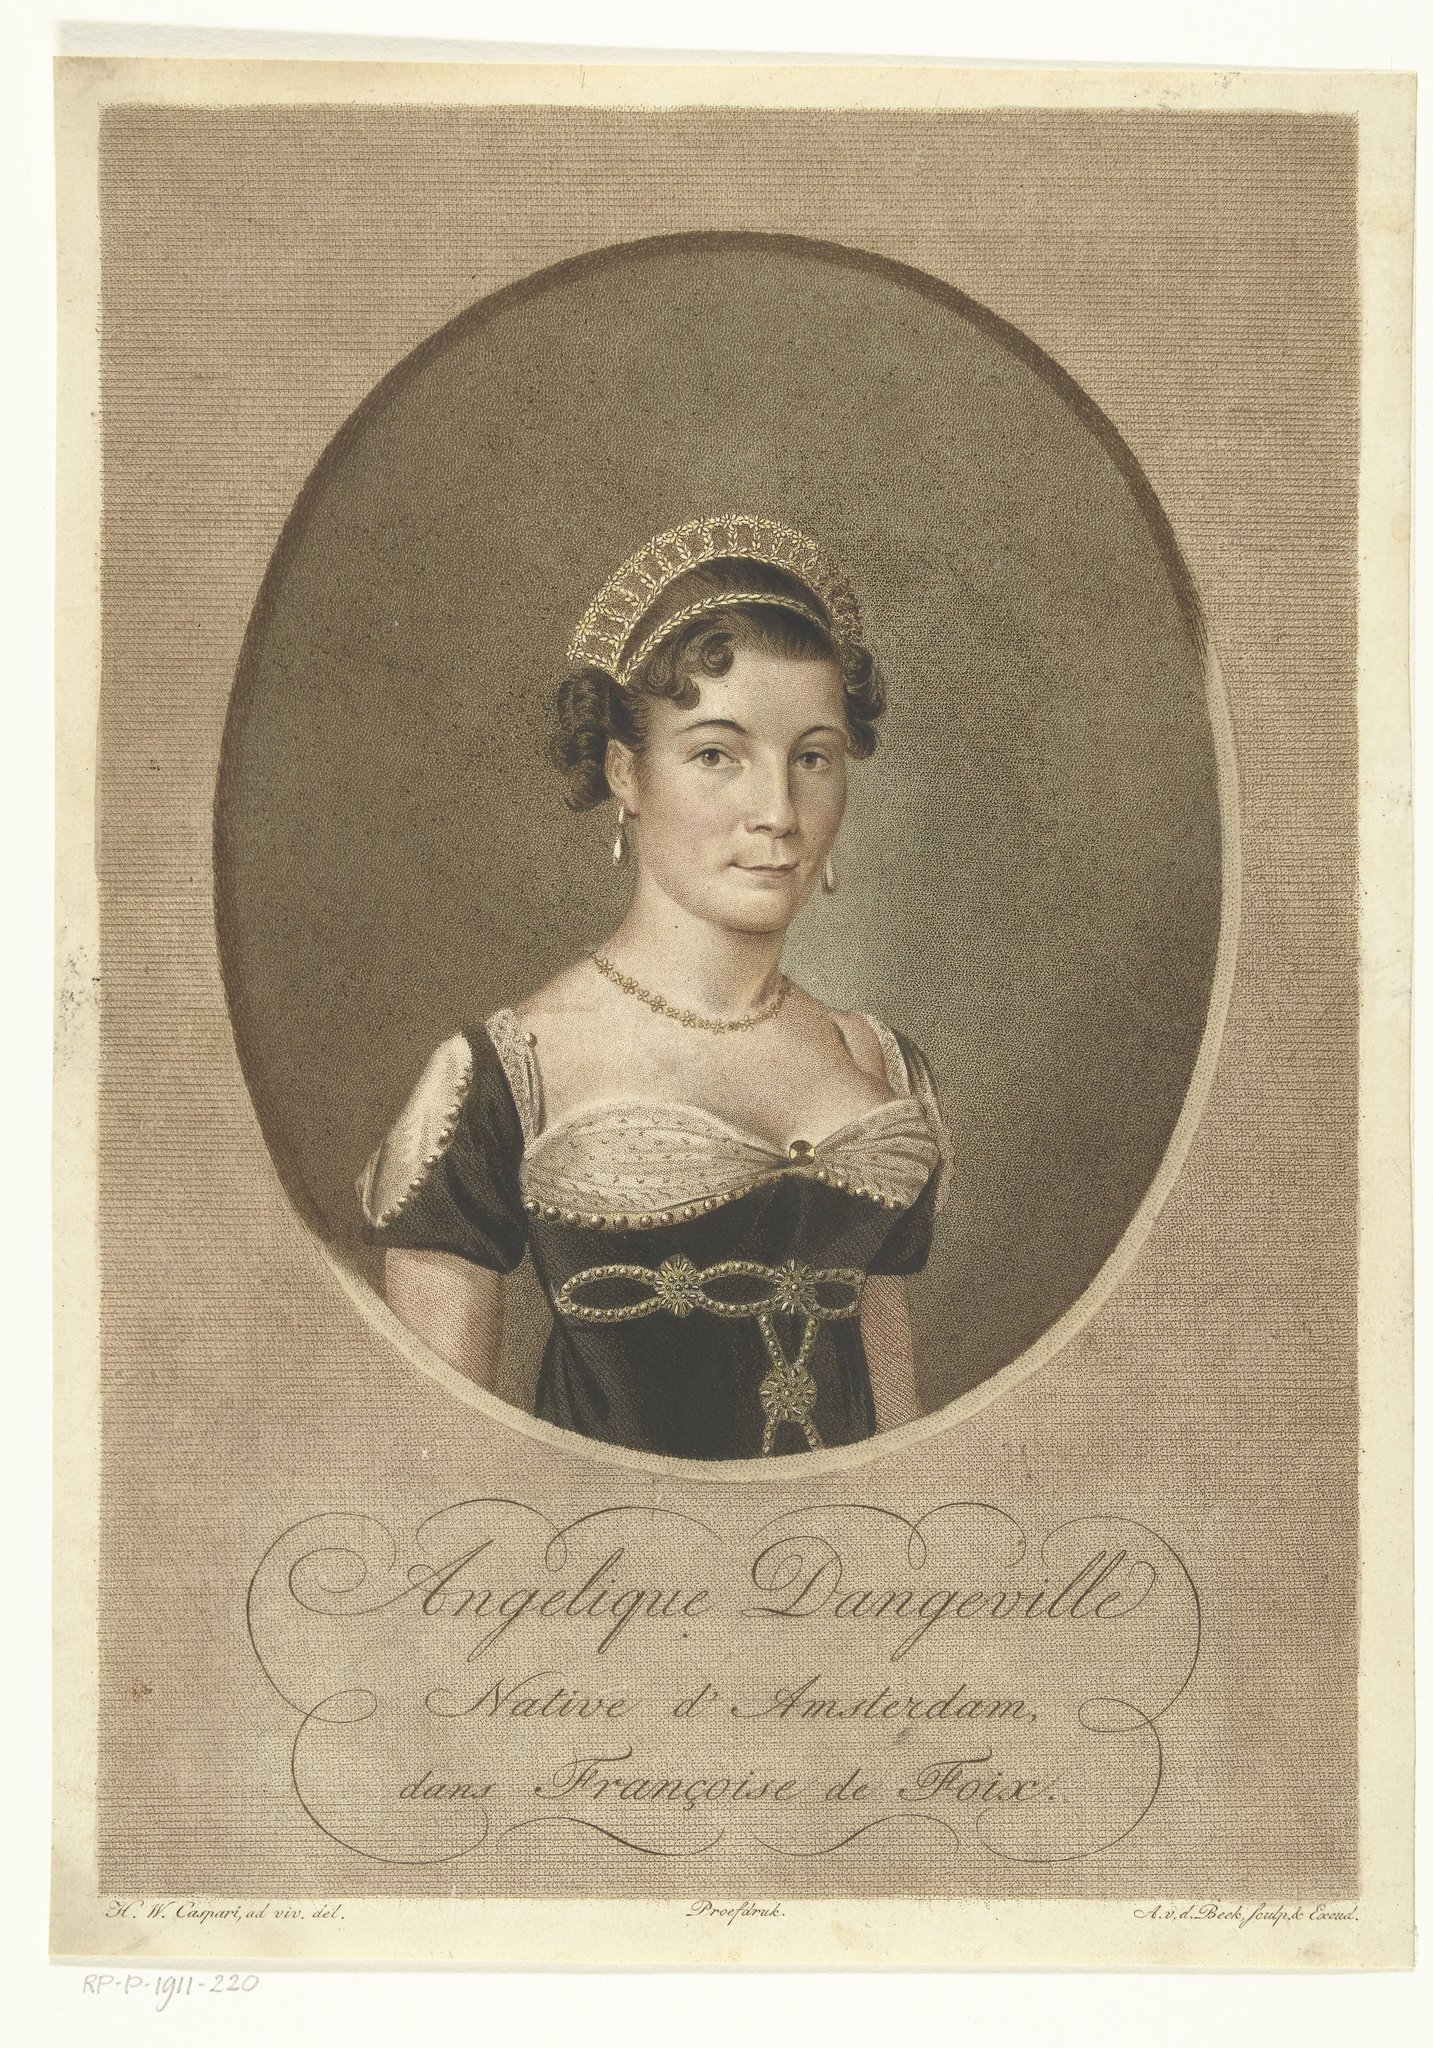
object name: print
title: Angélique Dangeville Native d'Amsterdam dans Françoise de Foix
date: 1793-1852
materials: paper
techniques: aquatint, etching, hand coloring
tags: portrait of actor, actress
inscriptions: collector's mark: Lugt 2228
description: Prent naar tekening van Hendrik Willem Caspari.